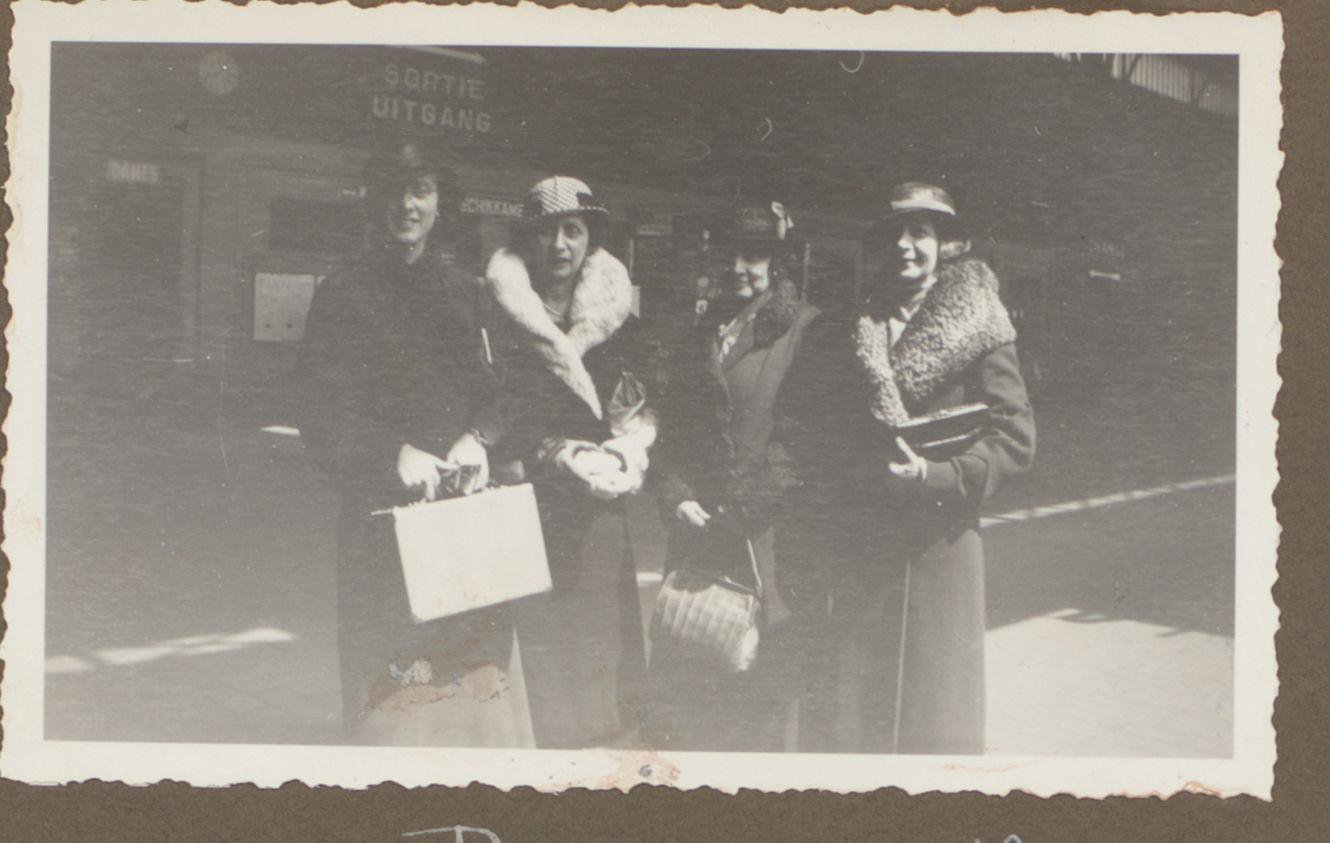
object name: album leaf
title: Bertha, Henriëtte en Tootje Wassink met een vierde vrouw op een station, Brussel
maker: Anonymous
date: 1905-1933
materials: paper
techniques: gelatin silver print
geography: brussels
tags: batavia, the hague, henriëtte wassink, historical persons - bb - woman, station; shelter (railway, tramway), brussels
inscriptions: inscription: ‘Brussel - Mei - 1933’